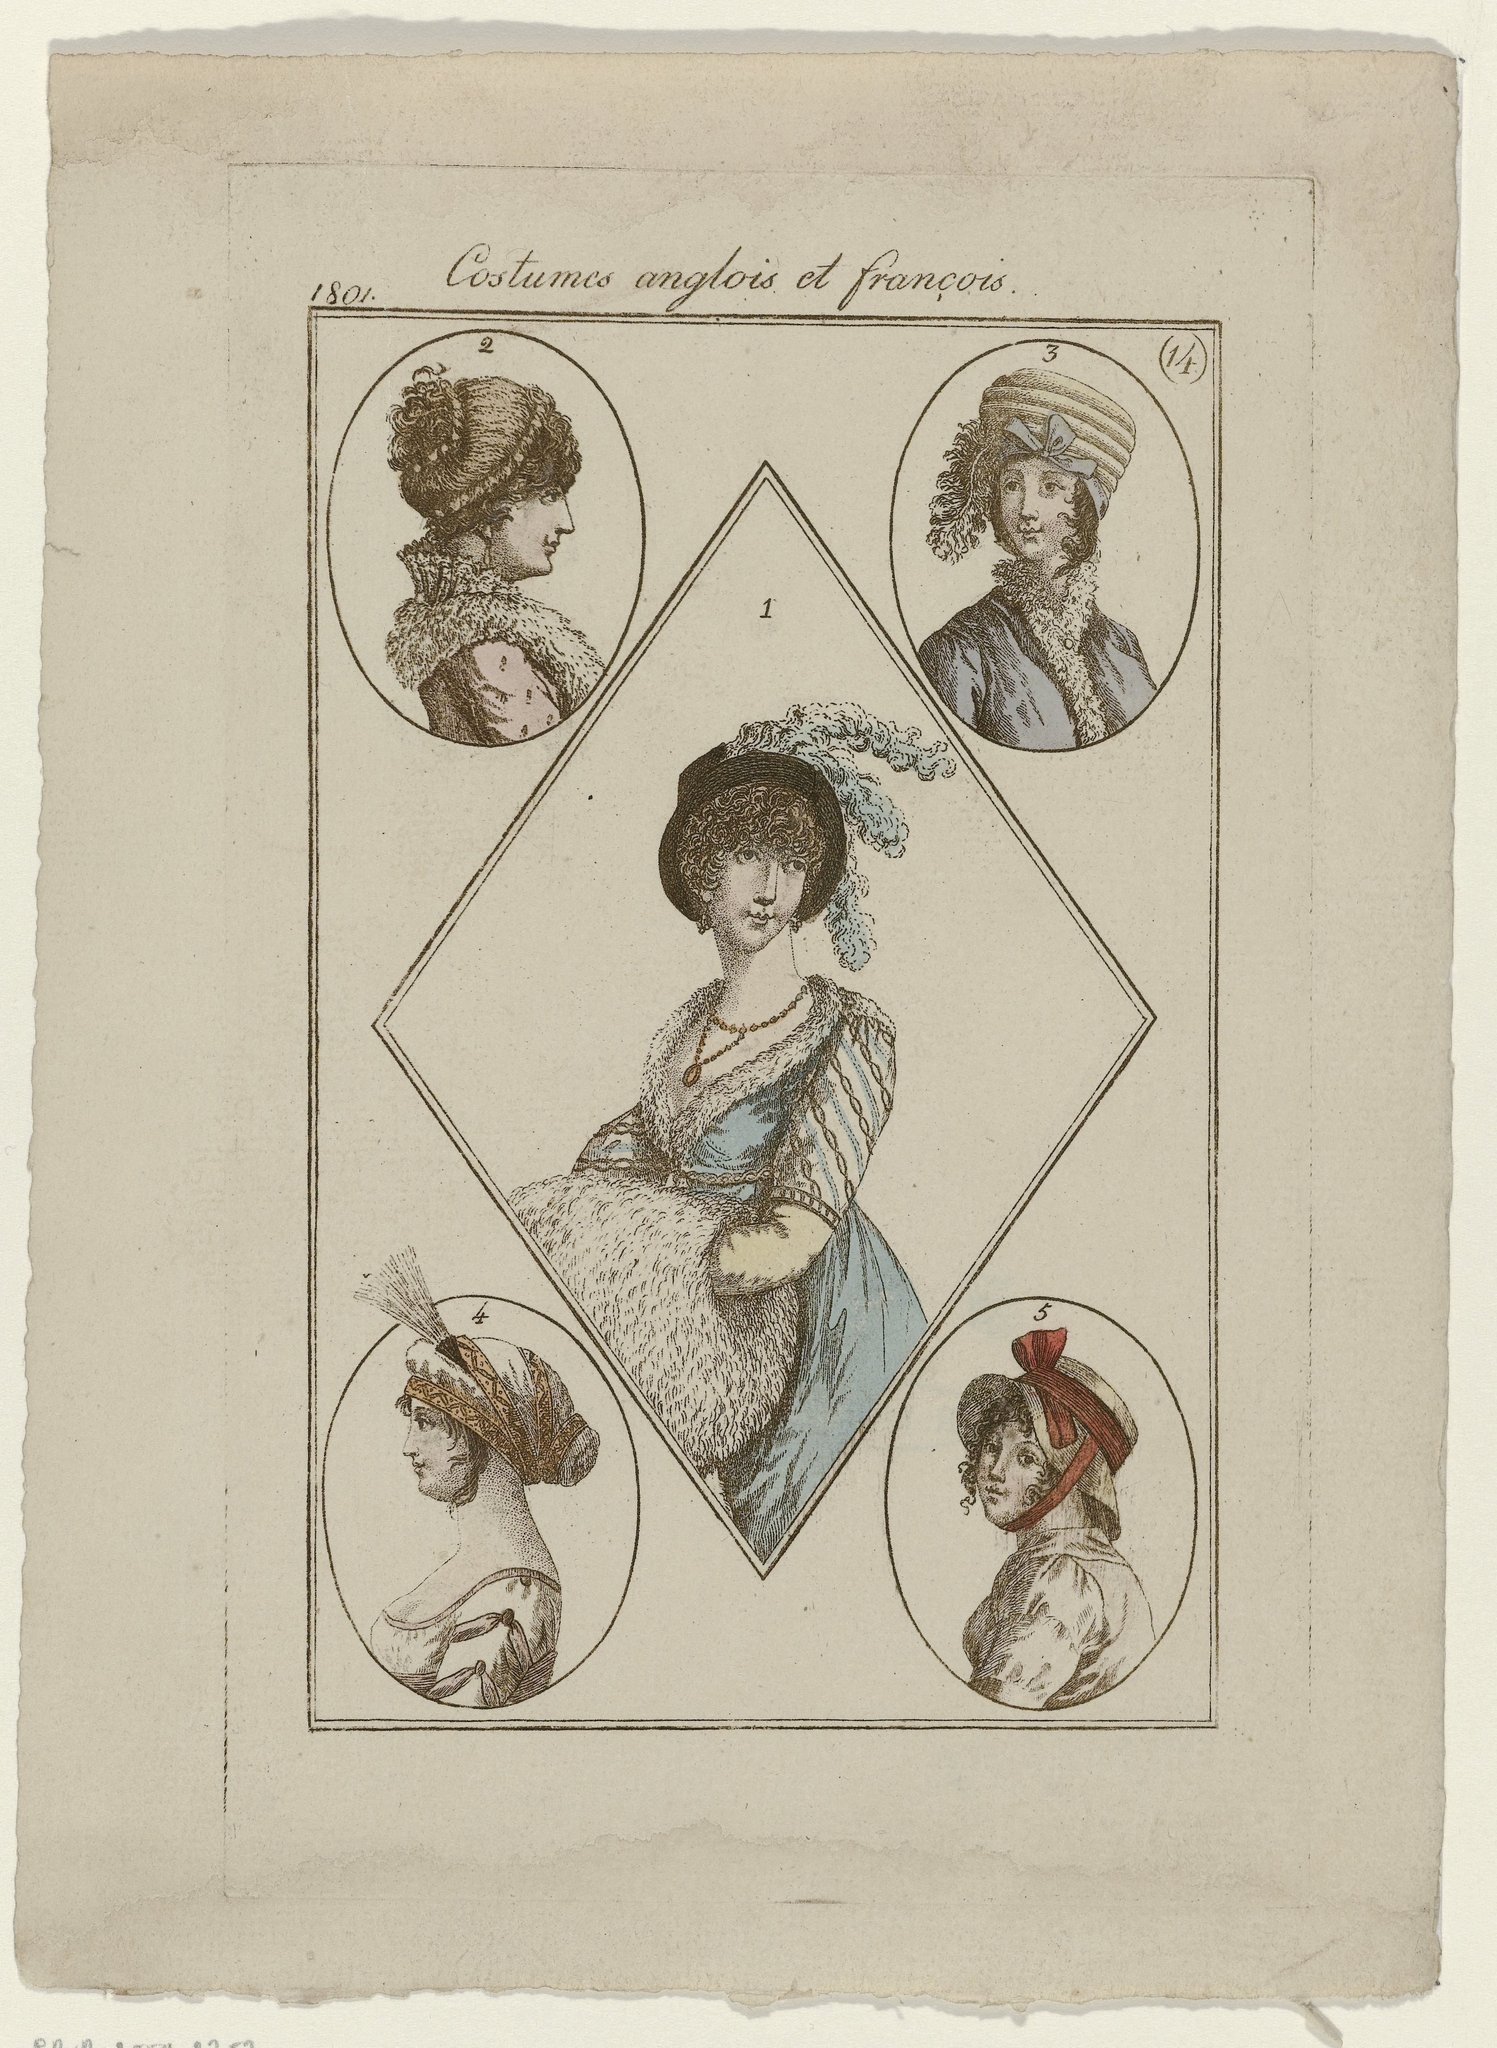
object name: fashion print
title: Journal des Dames et des Modes, editie Frankfurt 1801, Costumes anglois et françois, (14)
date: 1801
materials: paper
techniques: engraving, hand coloring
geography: frankfurt am main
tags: ear-rings (+ women's clothes), pendant, trinket, 'breloque' (+ women's clothes), head-gear: turban (+ women's clothes), fashion plates, head-gear: hat (+ women's clothes), gloves, mittens, etc. (+ women's clothes), dress, gown (+ women's clothes), muff (+ fur used for clothes)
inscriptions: title: ‘Costumes anglois et françois.’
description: Vrouw, ten halven lijve, in een diamantvormig kader (nr. 1). Zij draagt een japon met een kraag van bont. De handen in een mof van bont. Accessoires: hoed met veren, oorbellen, collier met medaillon. Vier vrouwenbustes in medaillons met verschillende hoofddeksels (nr. 2 t/m 5). Prent uit het modetijdschrift Journal des Dames et des Modes, Frankfurt-am-Main, 1798-1848.